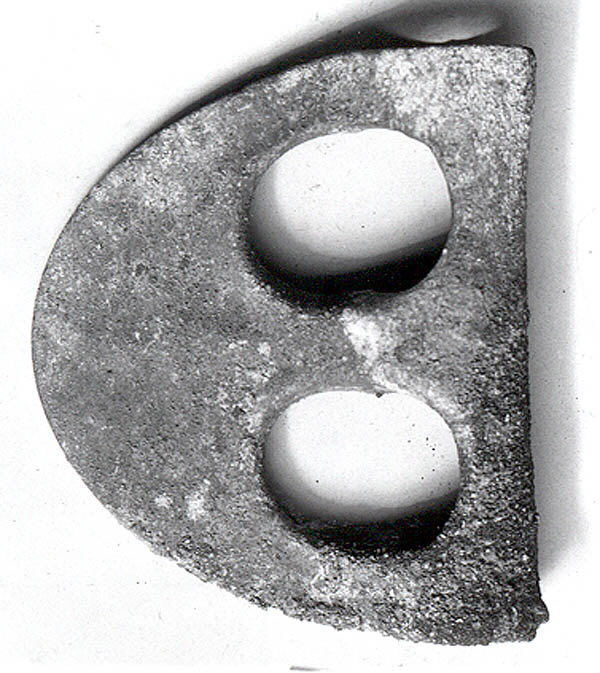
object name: axe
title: Fenestrated axe blade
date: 2000-1668 BCE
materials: bronze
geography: lebanon